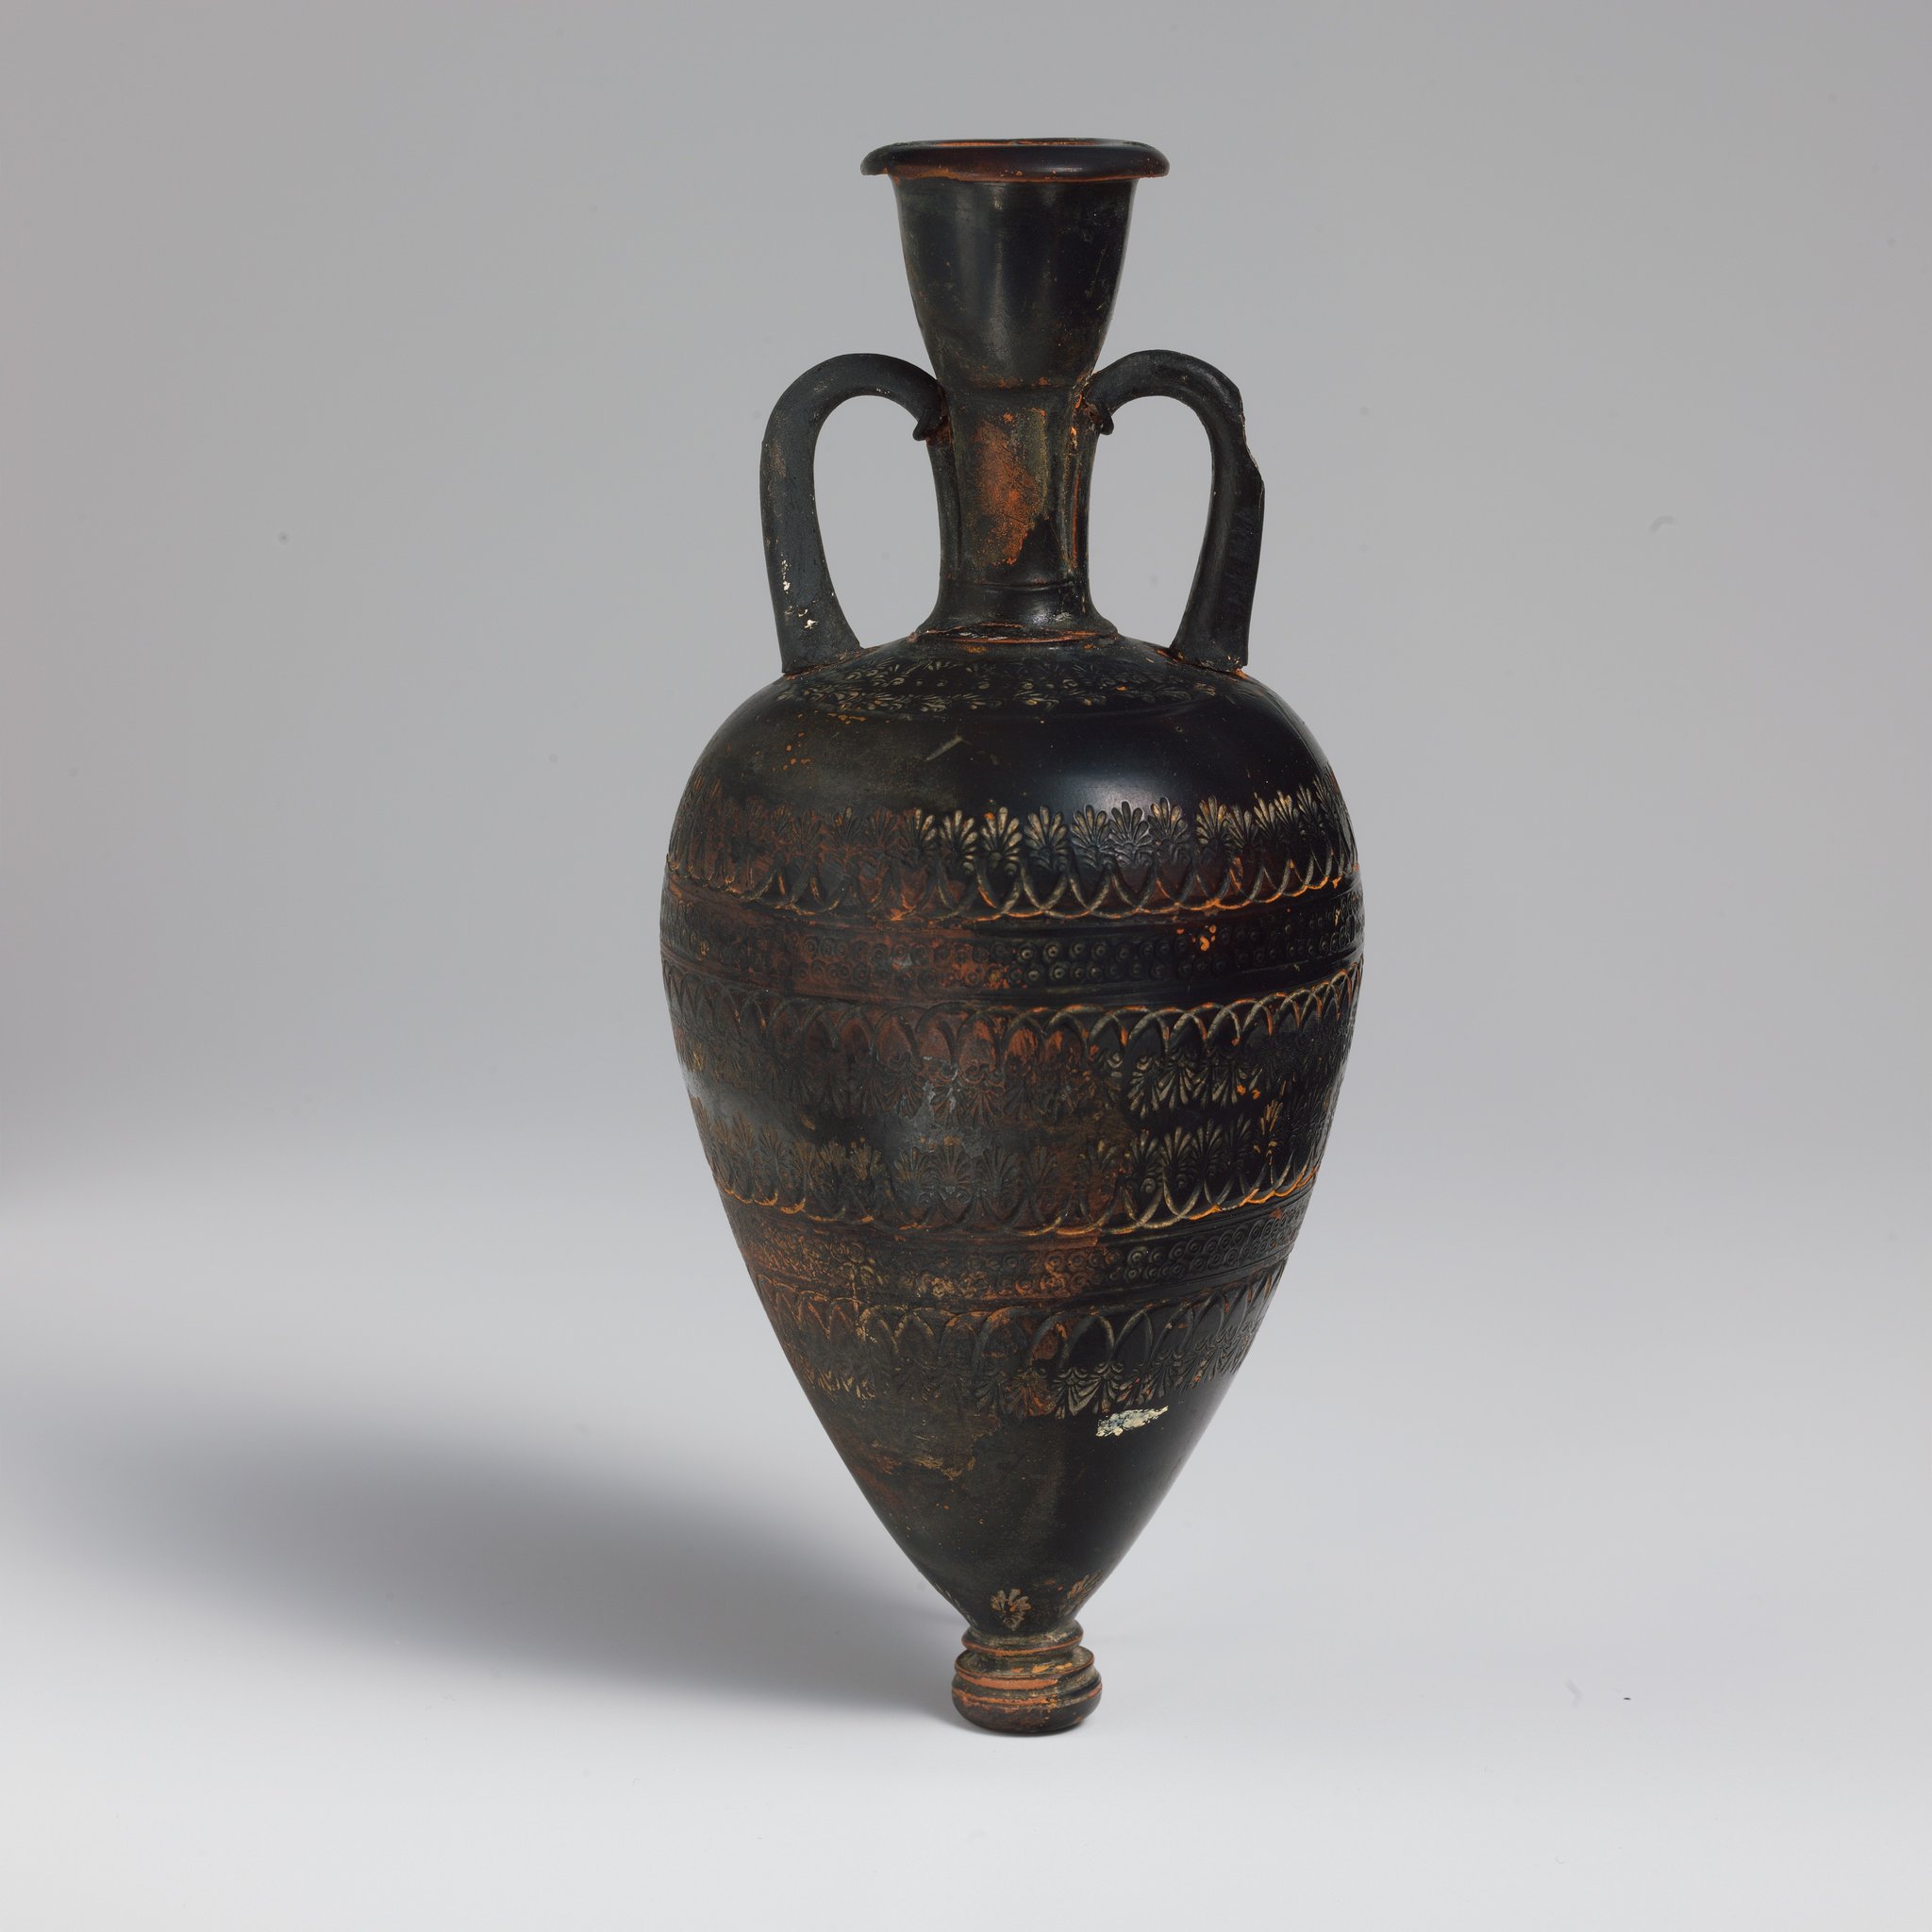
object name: amphoriskos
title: Terracotta amphoriskos (oil flask)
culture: greek, attic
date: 400-301 BCE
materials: terracotta